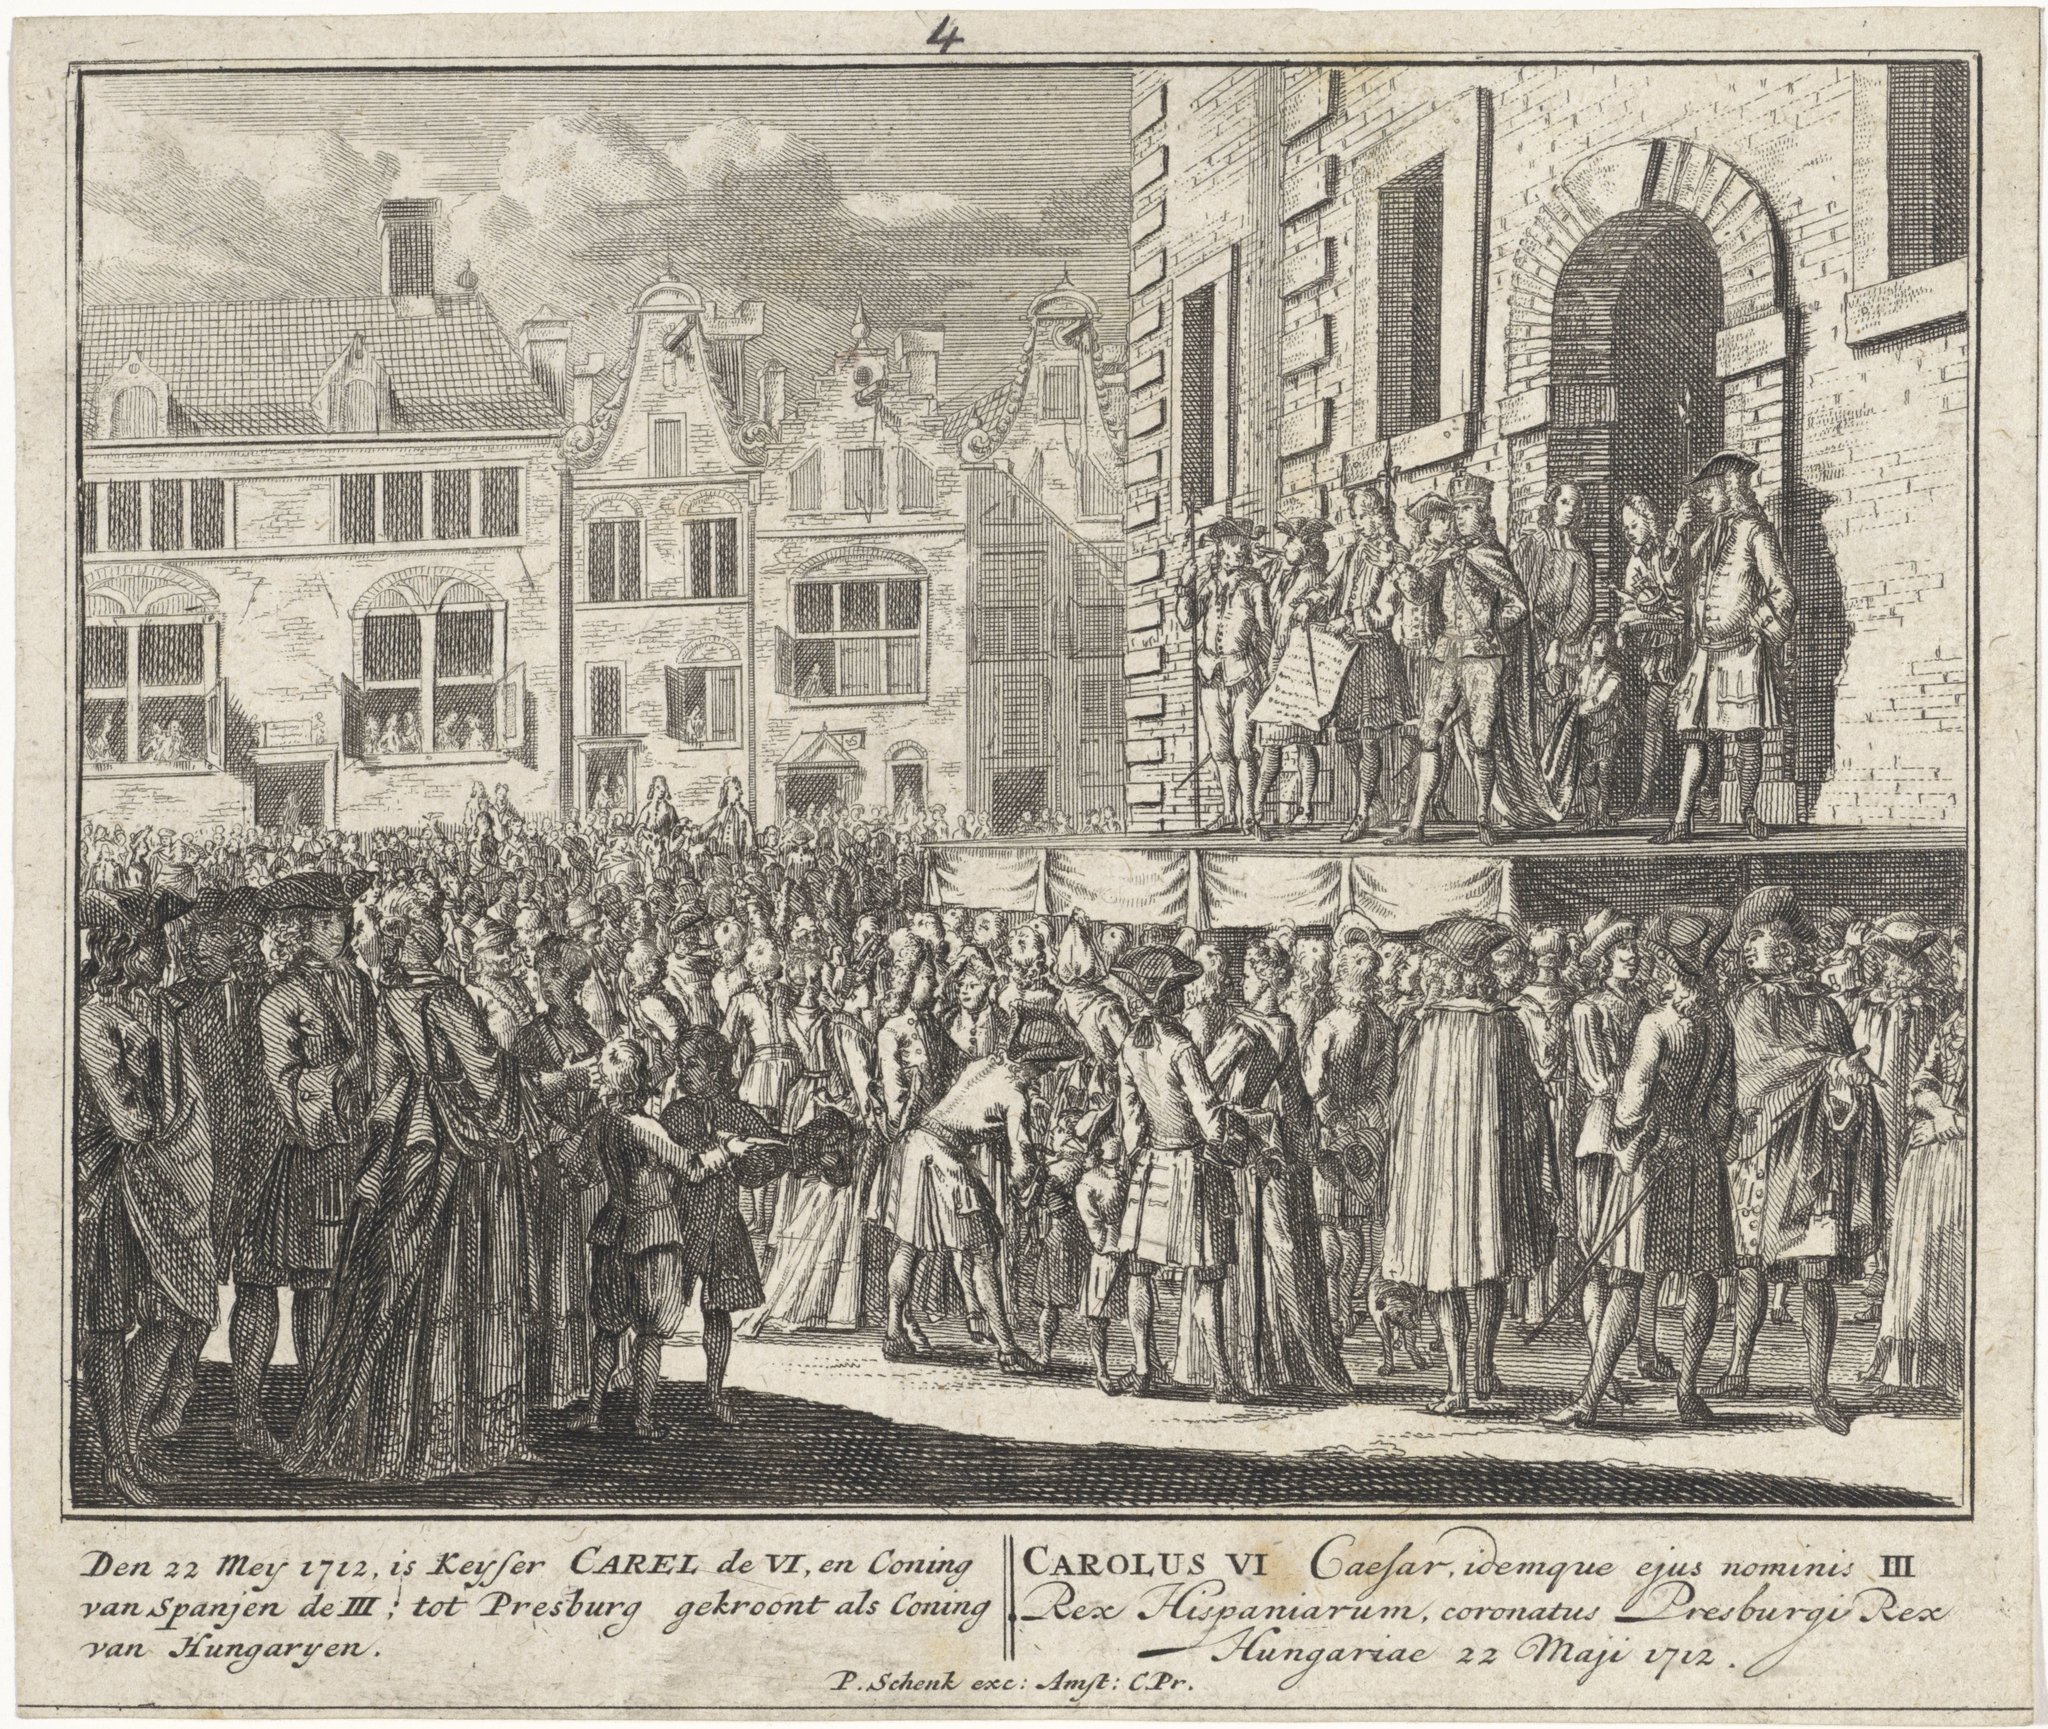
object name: book illustration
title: Den 22 Mey 1712, is Keyser Carel de VI, en Coning van Spanjen de III; tot Presburg gekroont als Coning van Hungaryen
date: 1720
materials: paper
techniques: etching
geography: amsterdam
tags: proclamation of a ruler, village square, place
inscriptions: collector's mark: Lugt 2228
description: Op een bordes wordt de kroning van Karel III tot koning van Hongarije bekendgemaakt. Het publiek is massaal toegestroomd. Linksonder een drieregelige tekst in het Nederlands met een toelichting op de voorstelling en rechts dezelfde toelichting in het Latijn.